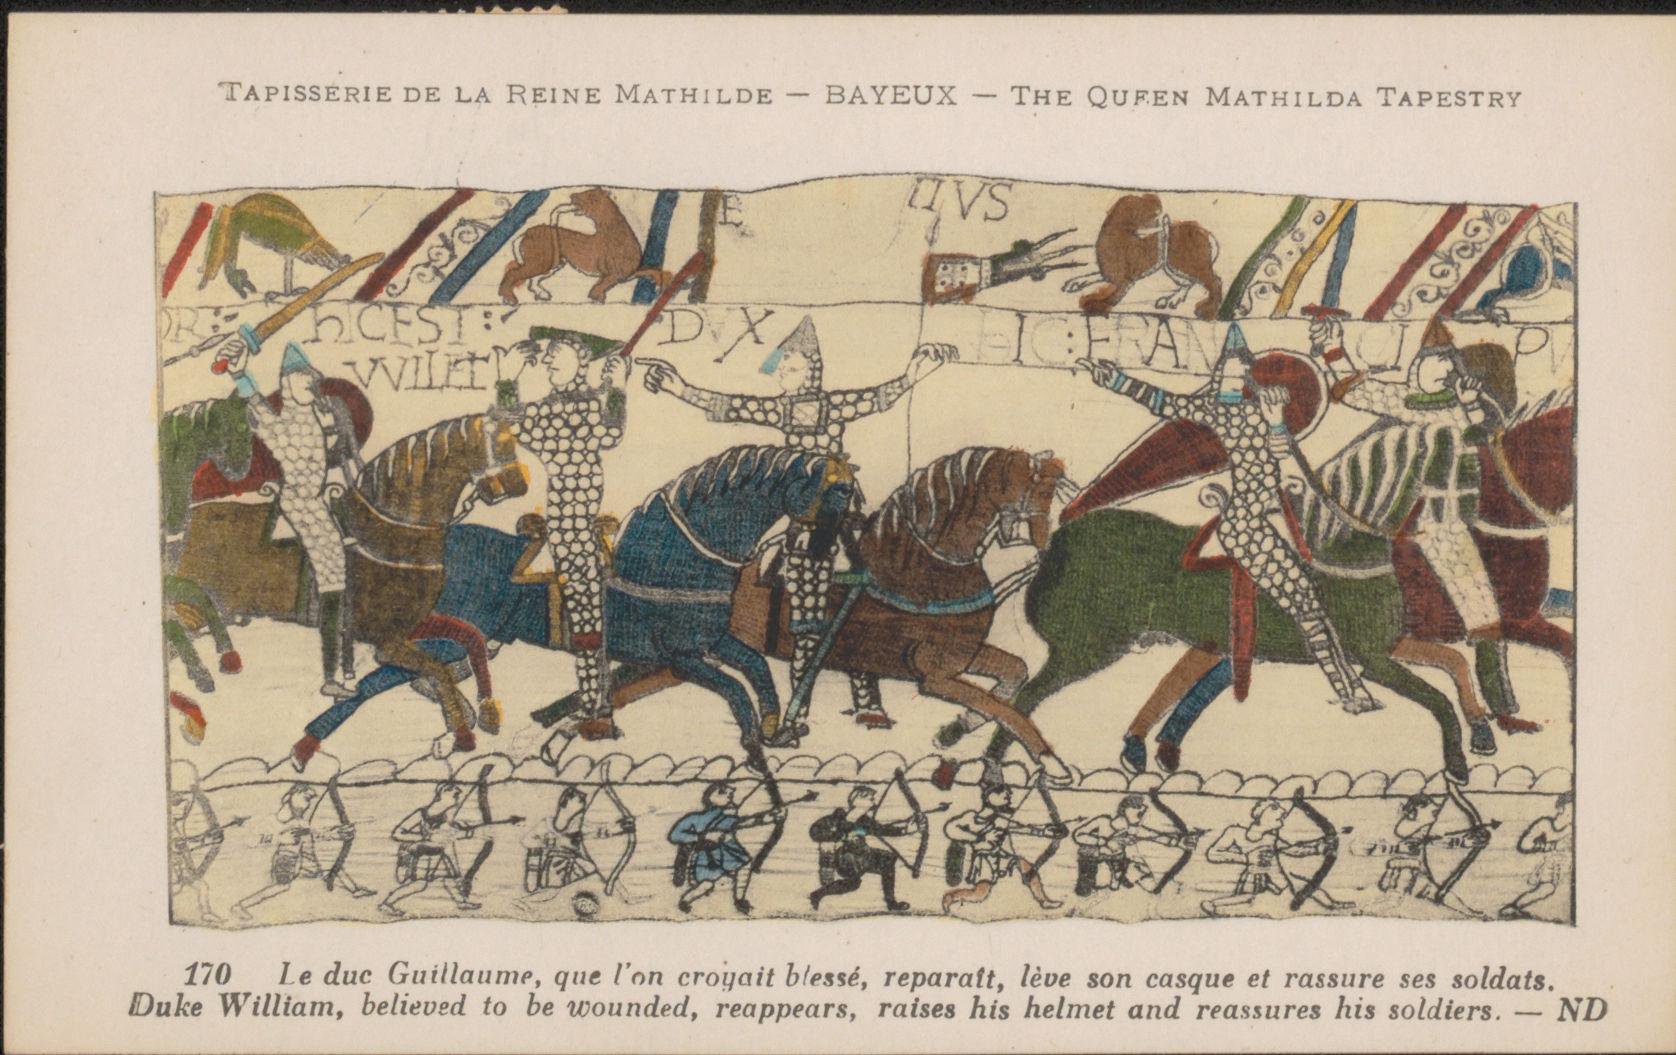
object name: ansichtkaart, prentbriefkaart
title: Prentbriefkaart aan Willem Bogtman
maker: richard nicolaüs roland holst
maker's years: 1868-1938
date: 1930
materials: cardboard, ink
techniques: photograph, pen, writing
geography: paris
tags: willem bogtman, applied arts, arts and crafts; industrial design